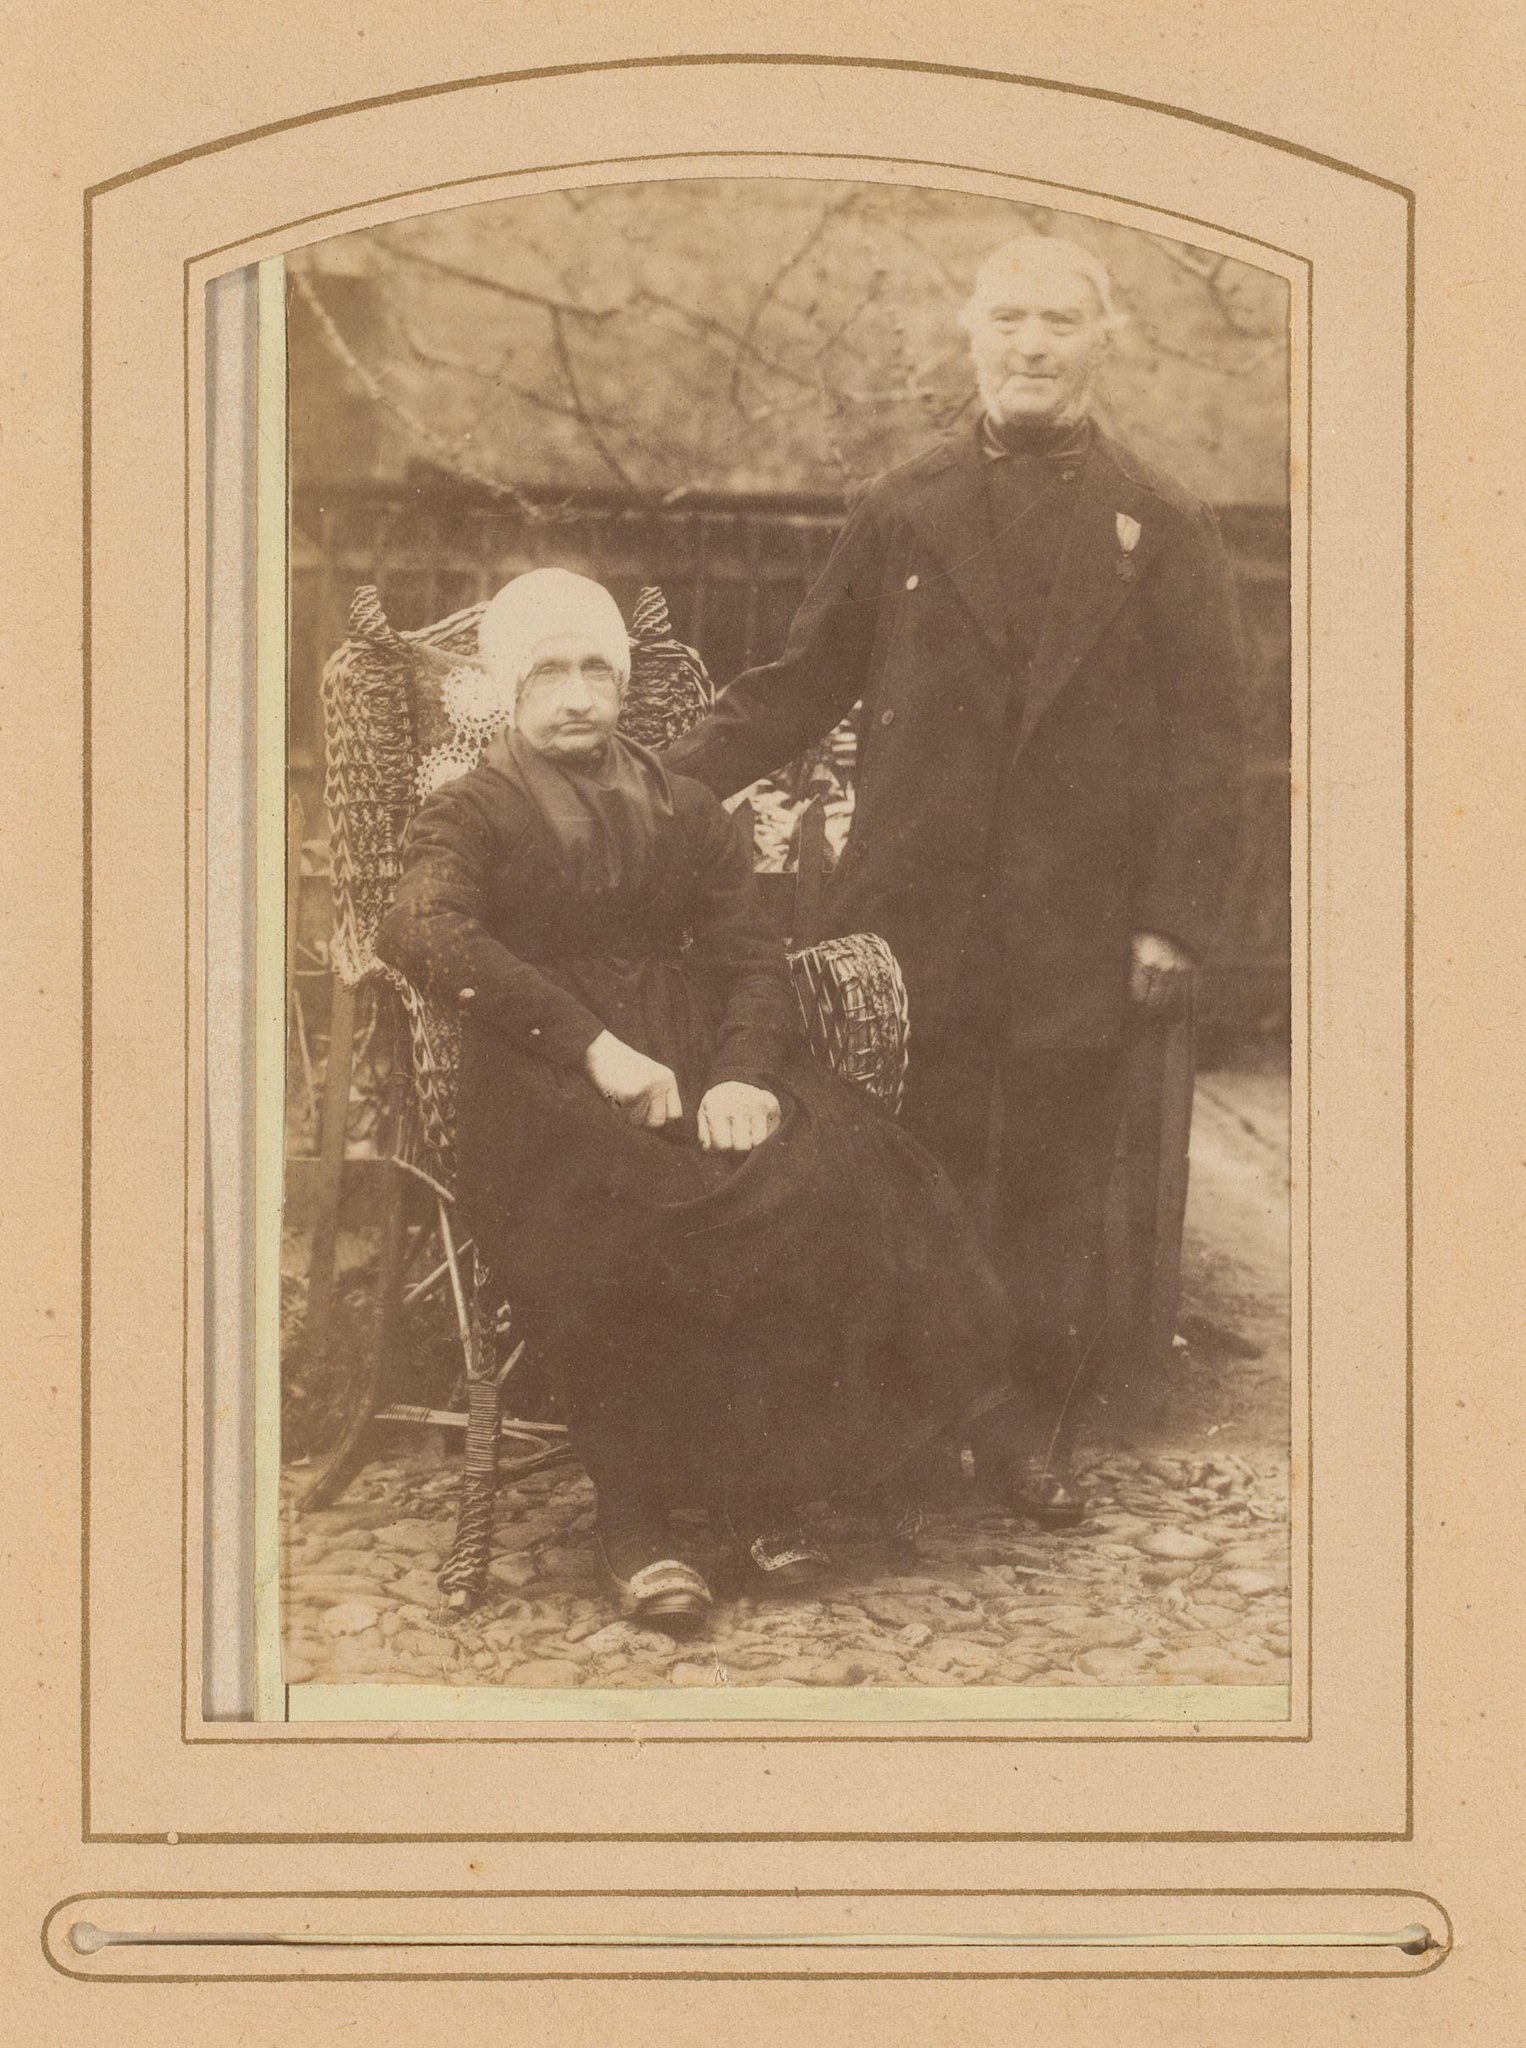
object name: photograph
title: Portret van een echtpaar, staande man en zittende vrouw in rieten tuinstoel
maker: h. frank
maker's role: fotograaf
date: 1860-1900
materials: cardboard, photographic support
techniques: albumen print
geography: groningen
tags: historical persons - bb - woman, historical persons, head-gear: cap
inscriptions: inscription: ‘H. Frank/ Rabenhauptstraat/ Groningen’